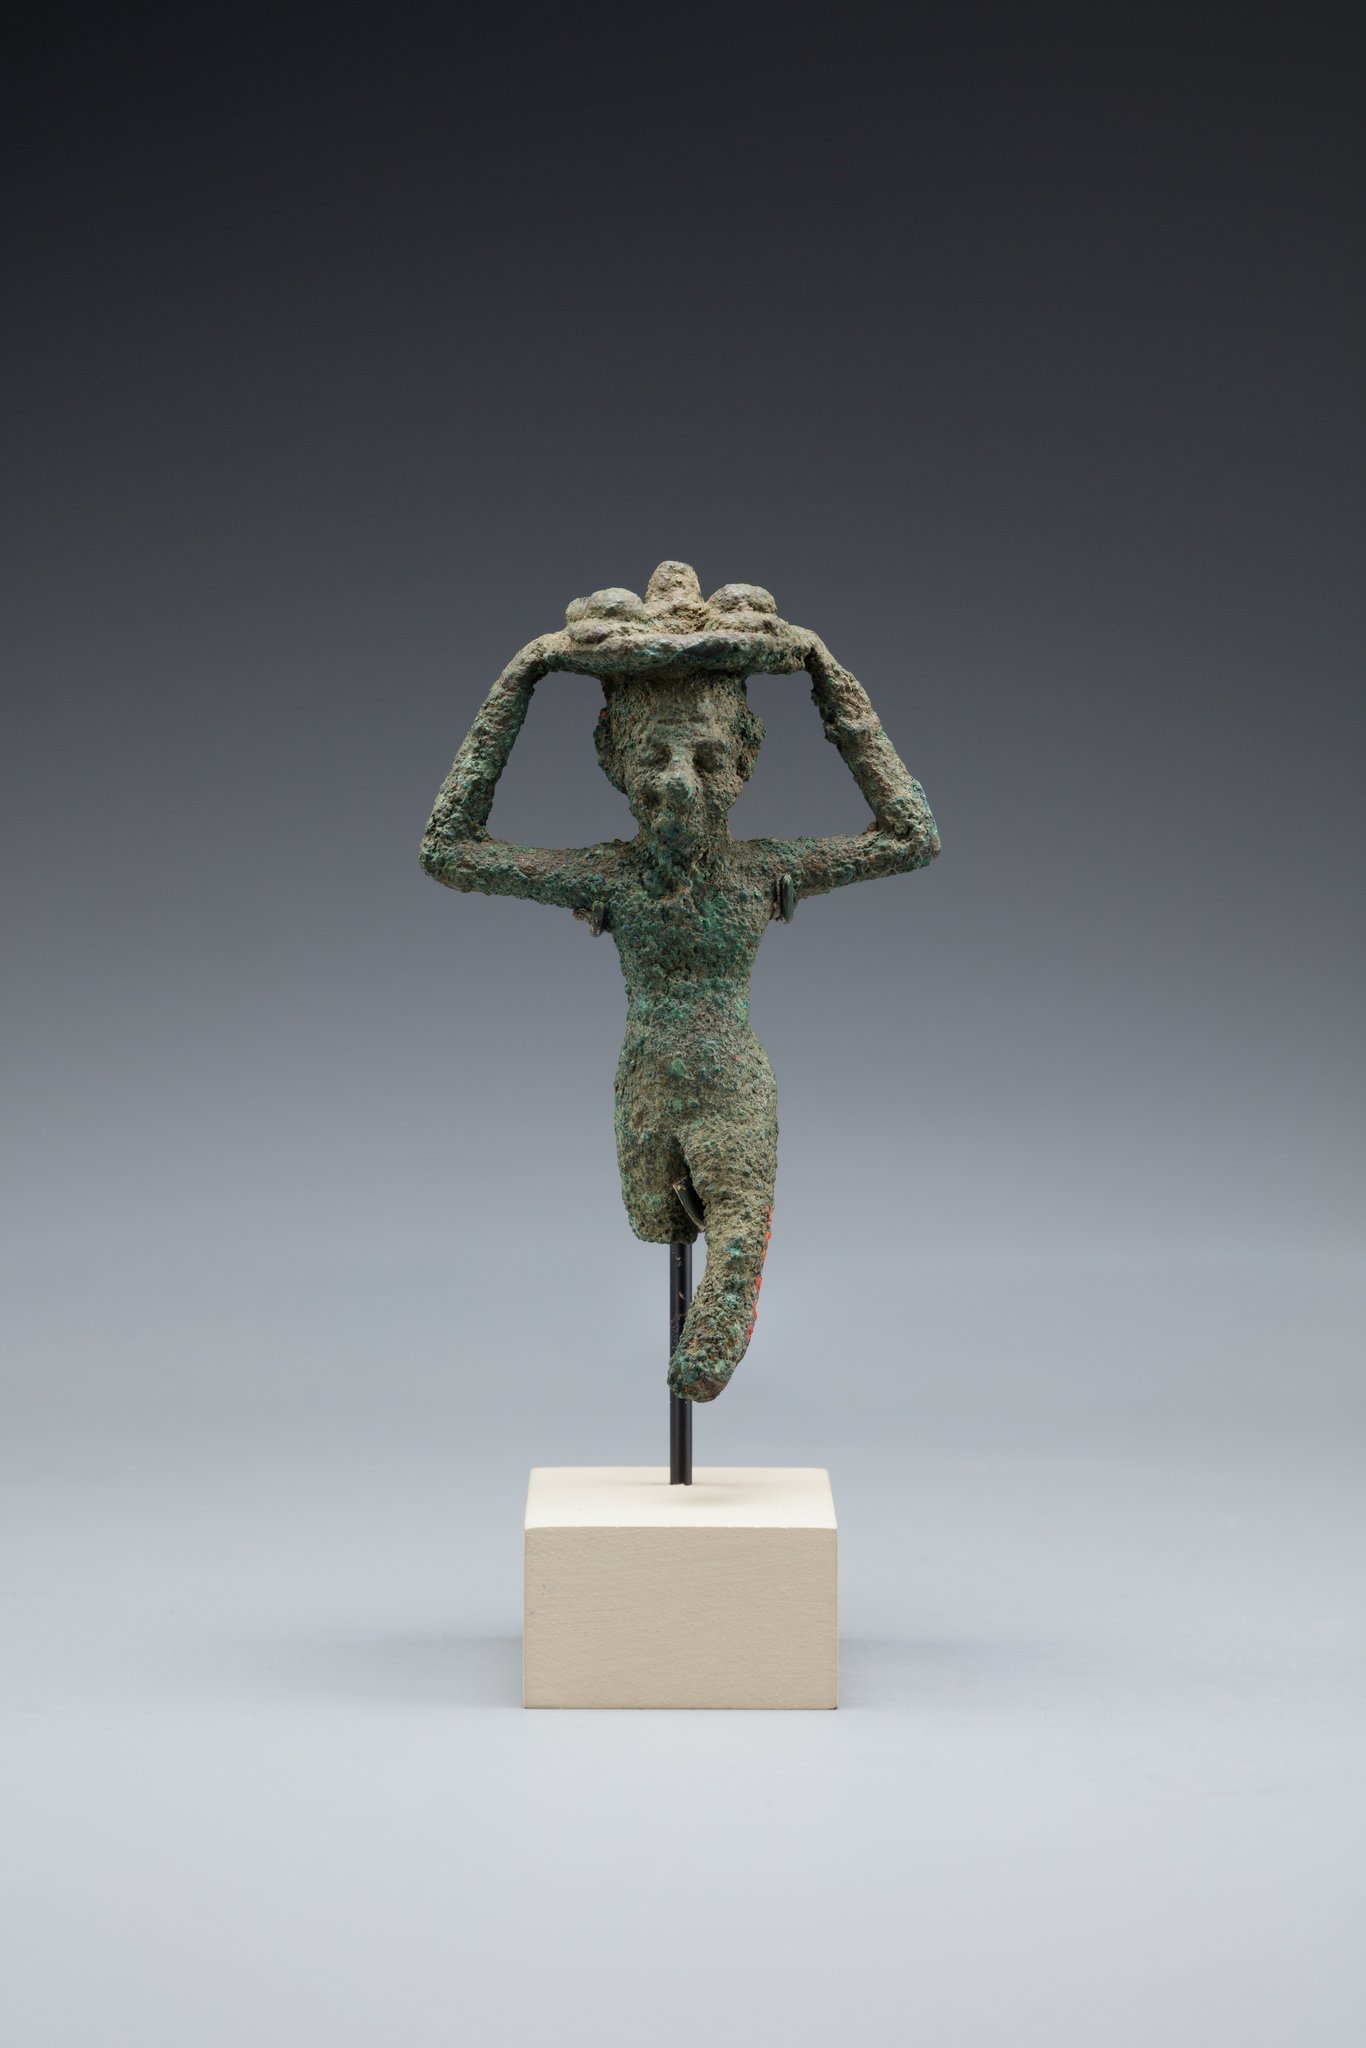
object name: figurine, man, tray of loaf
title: Man carrying a tray of loaves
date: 664-630 BCE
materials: alloy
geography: egypt